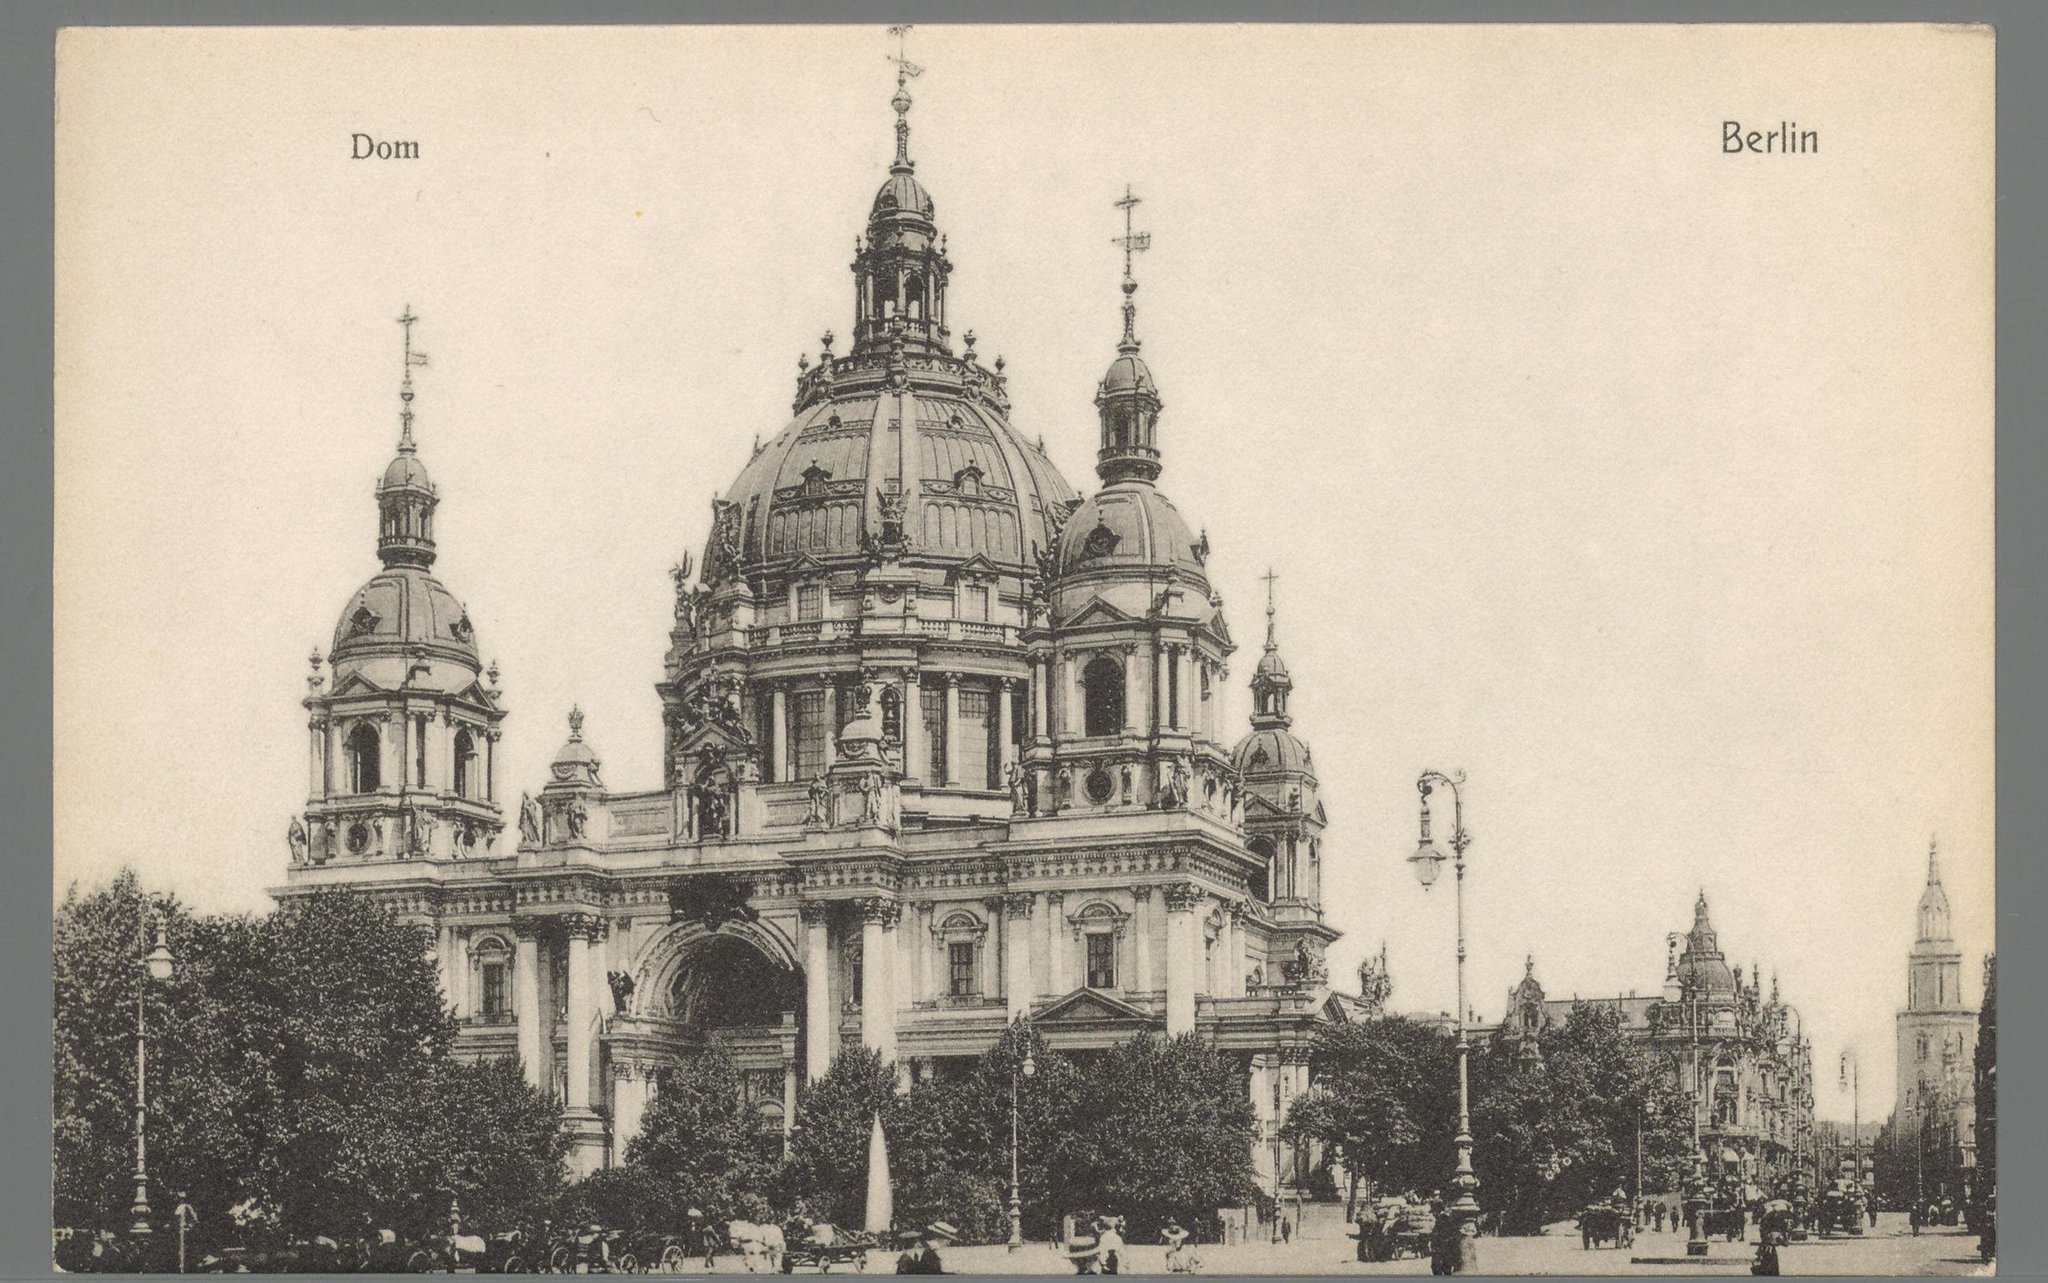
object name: ansichtkaart, prentbriefkaart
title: Dom. Berlin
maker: Anonymous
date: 1905-1930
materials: cardboard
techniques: photograph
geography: berlin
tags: church (exterior)